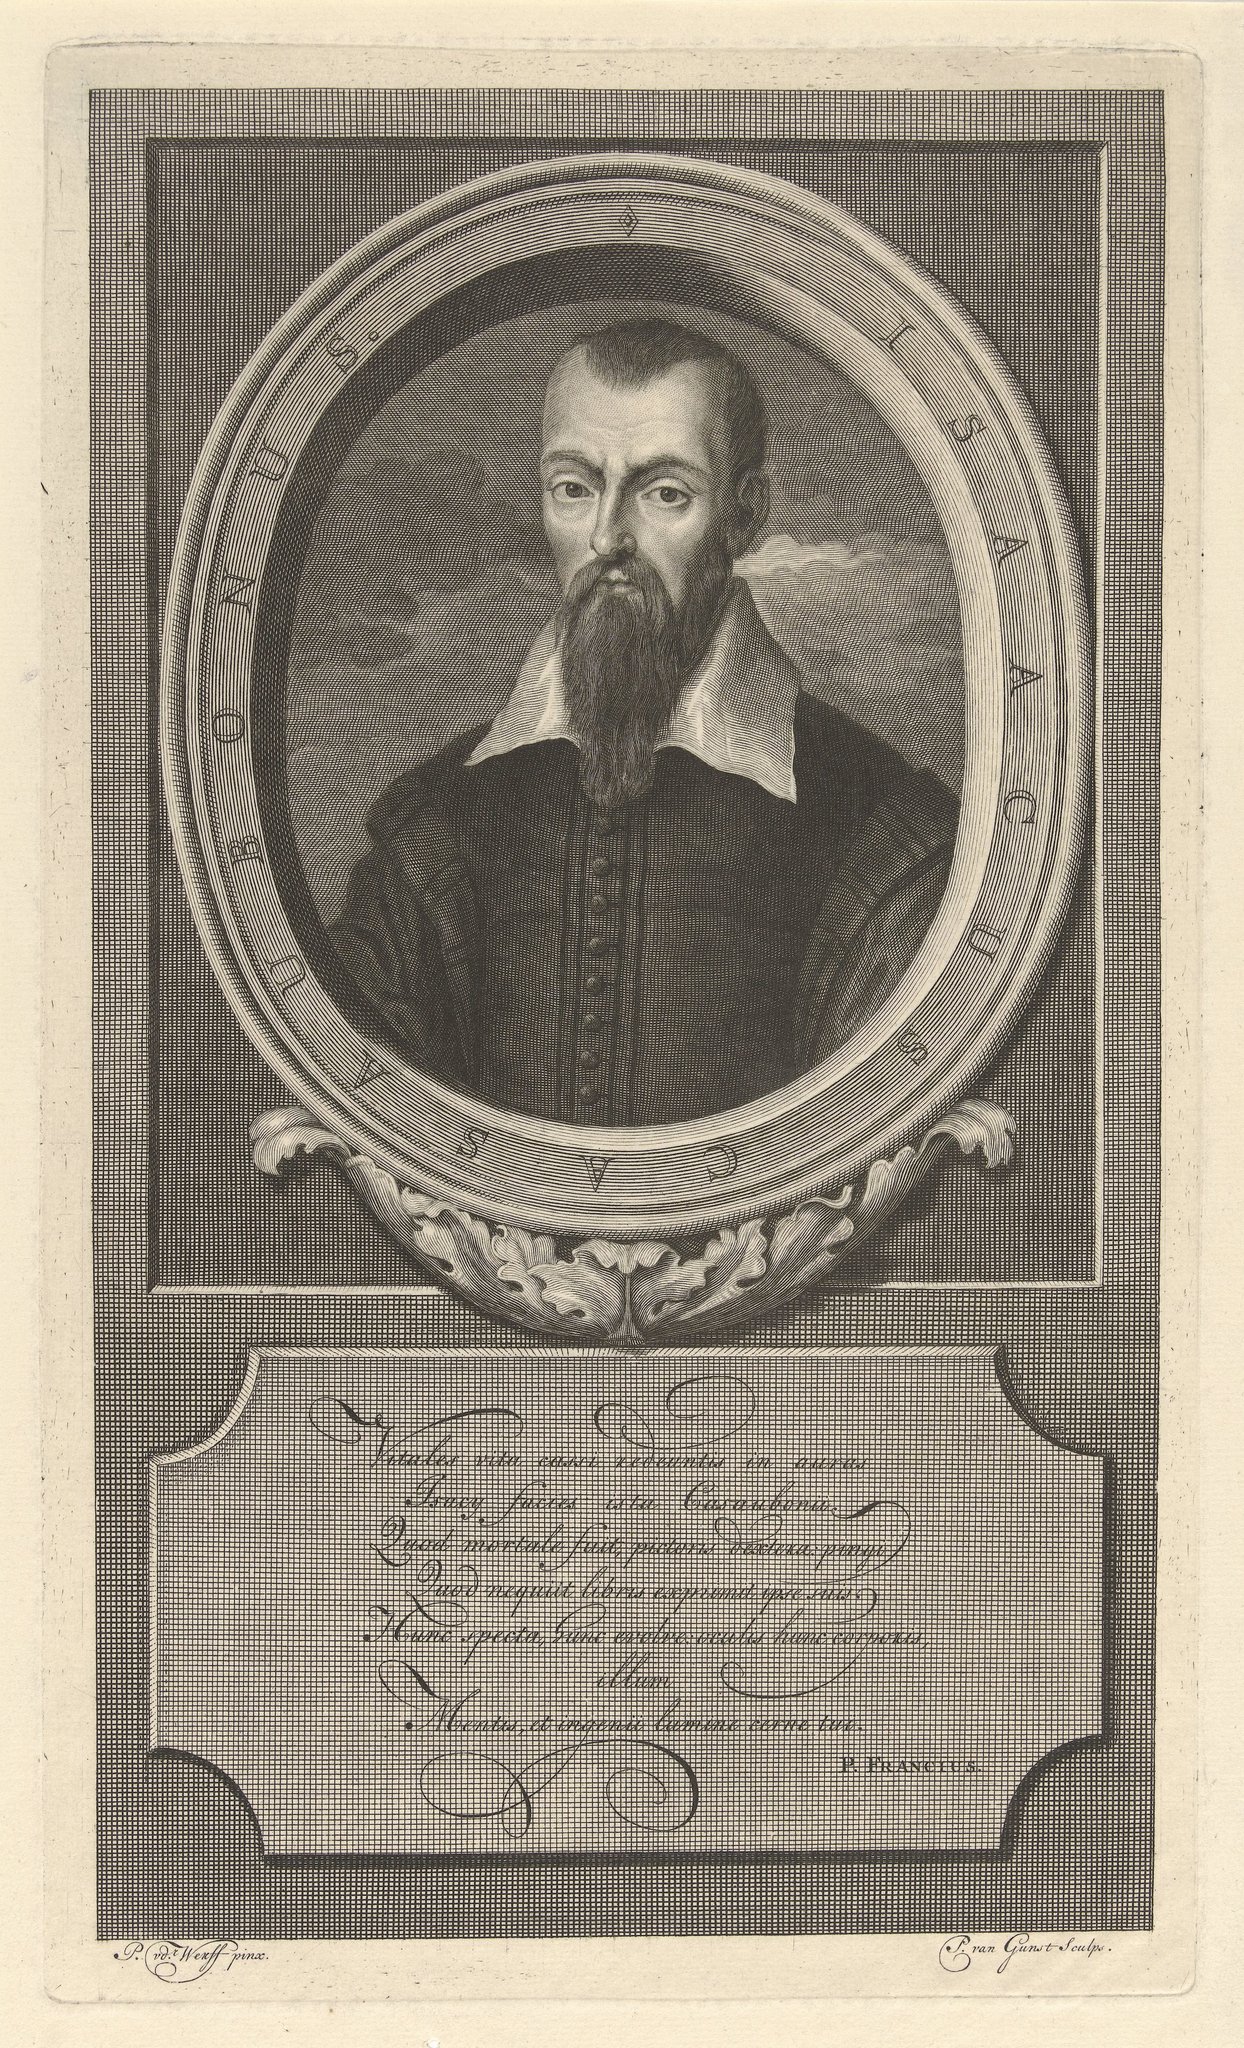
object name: print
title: Portret van Isaac Casaubon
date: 1669-1731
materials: paper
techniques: engraving, etching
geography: amsterdam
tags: isaac casaubon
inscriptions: collector's mark: Lugt 240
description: Isaac Casaubon, een Frans-Engelse filoloog en geleerde. De prent heeft als onderschrift een Frans gedicht over zijn leven.